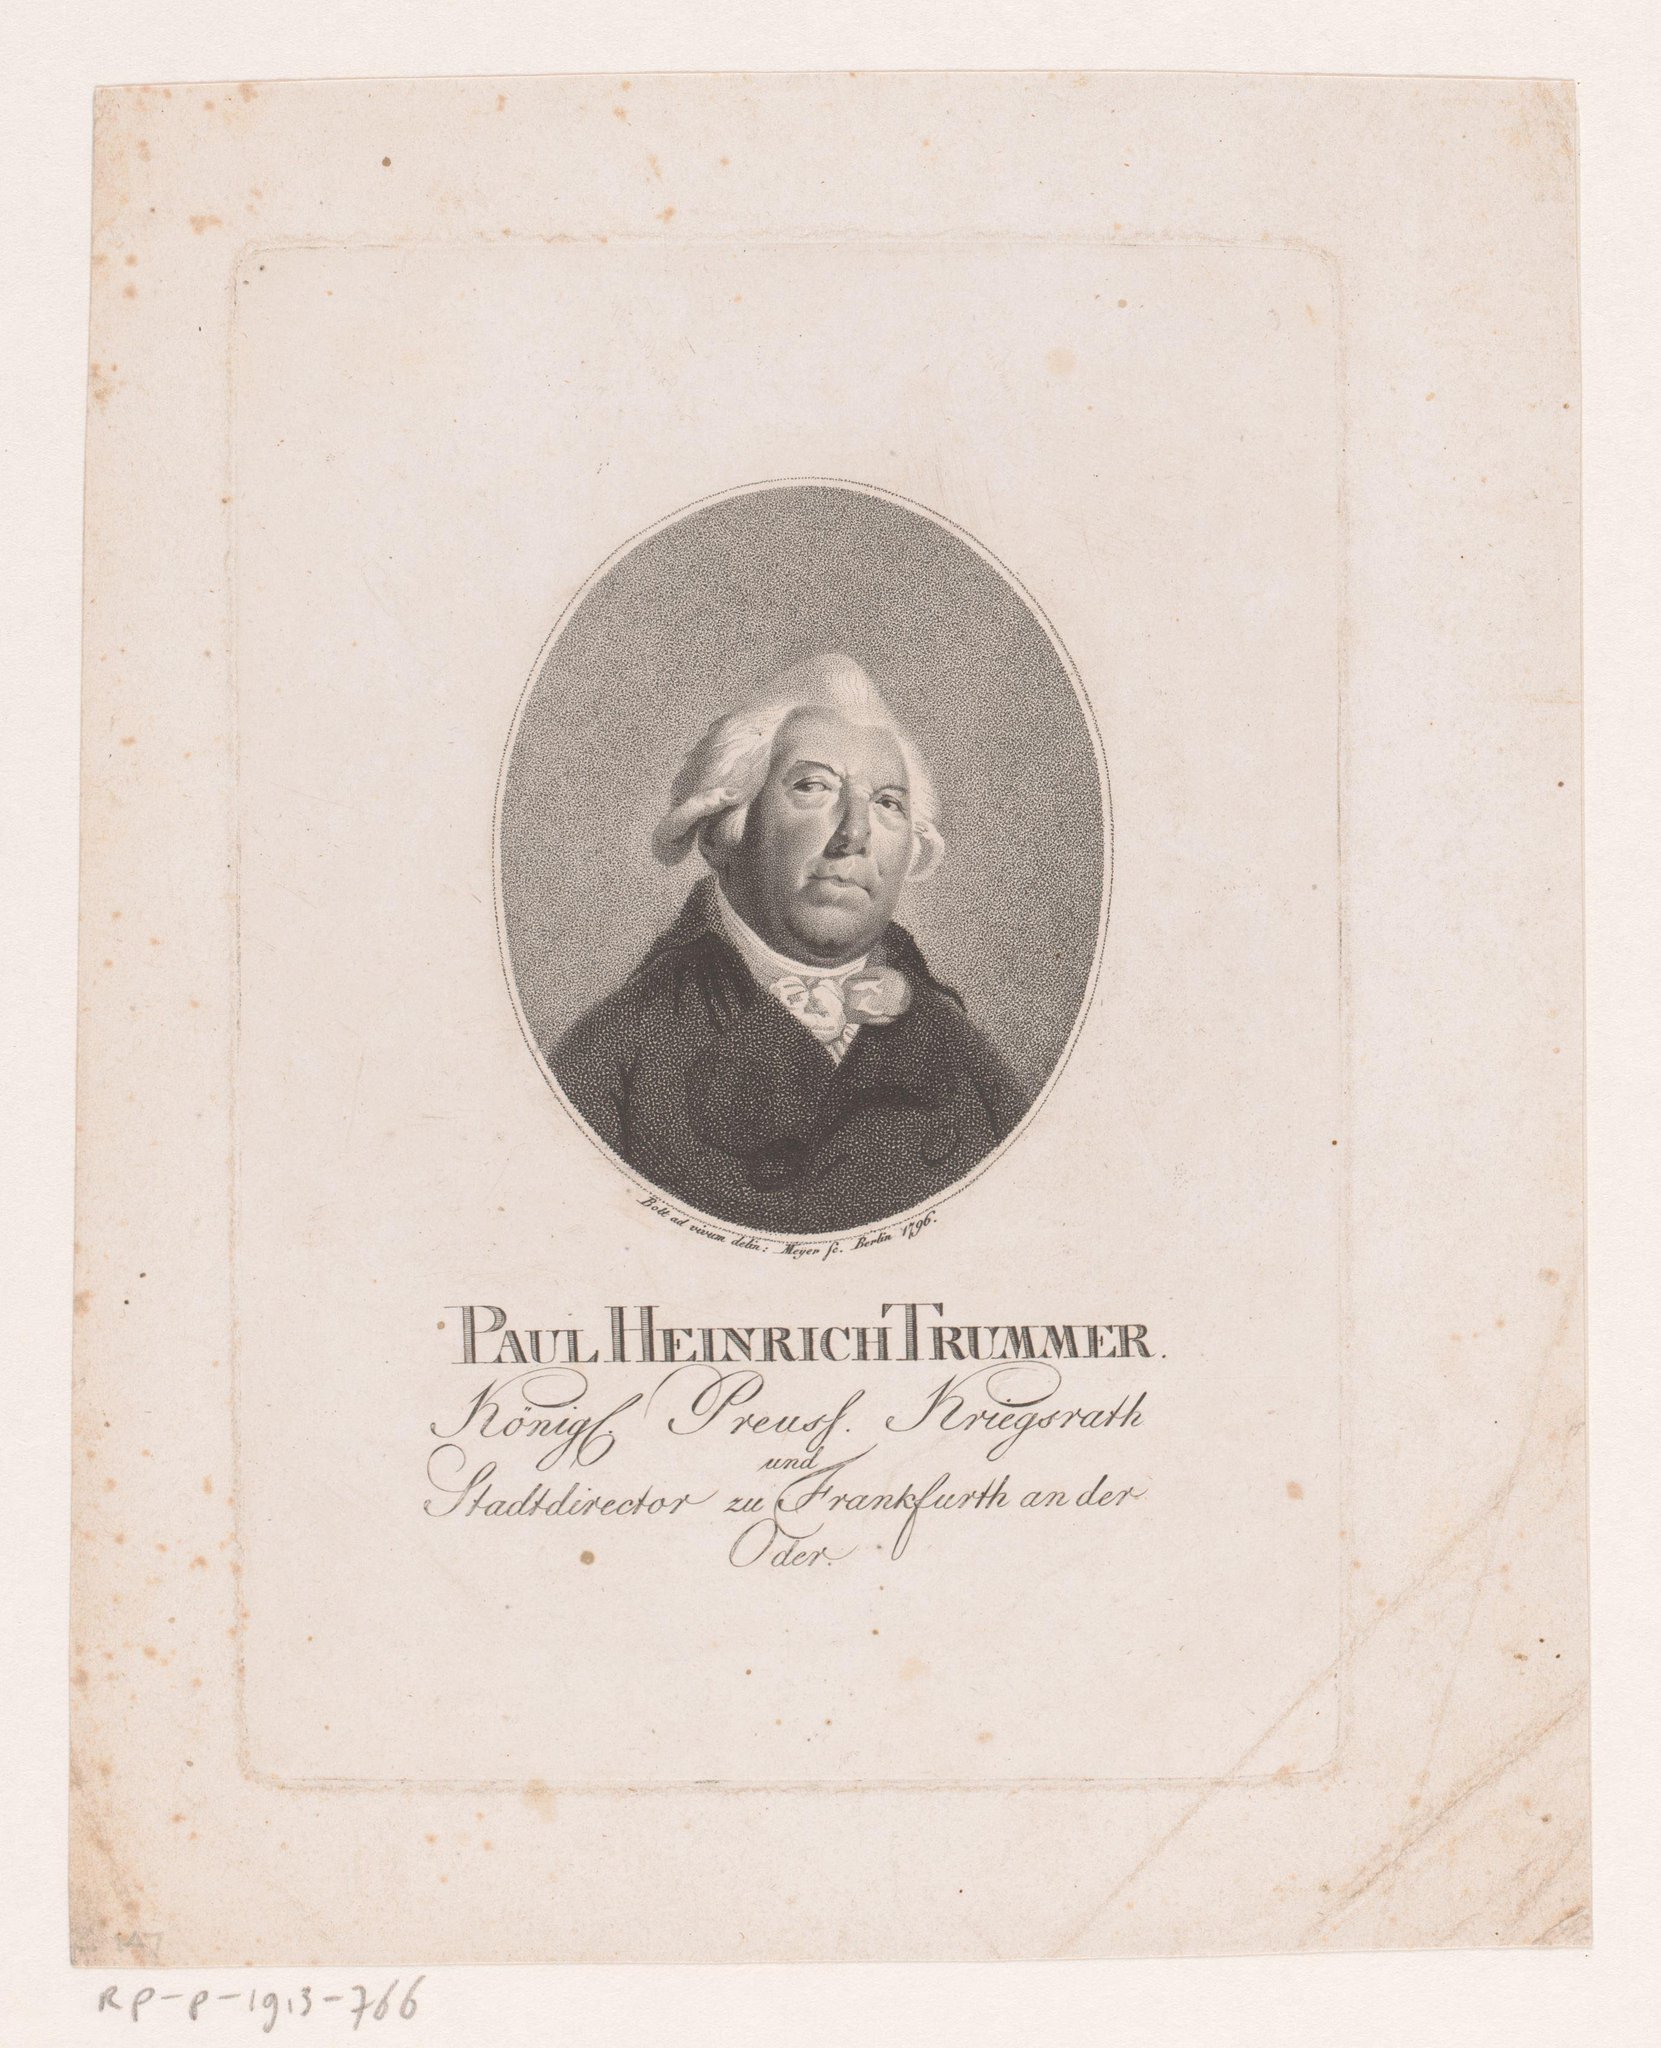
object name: print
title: Portret van Paul Heinrich Trummer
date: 1780-1880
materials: paper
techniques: engraving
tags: historical persons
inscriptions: collector's mark: Lugt 2228